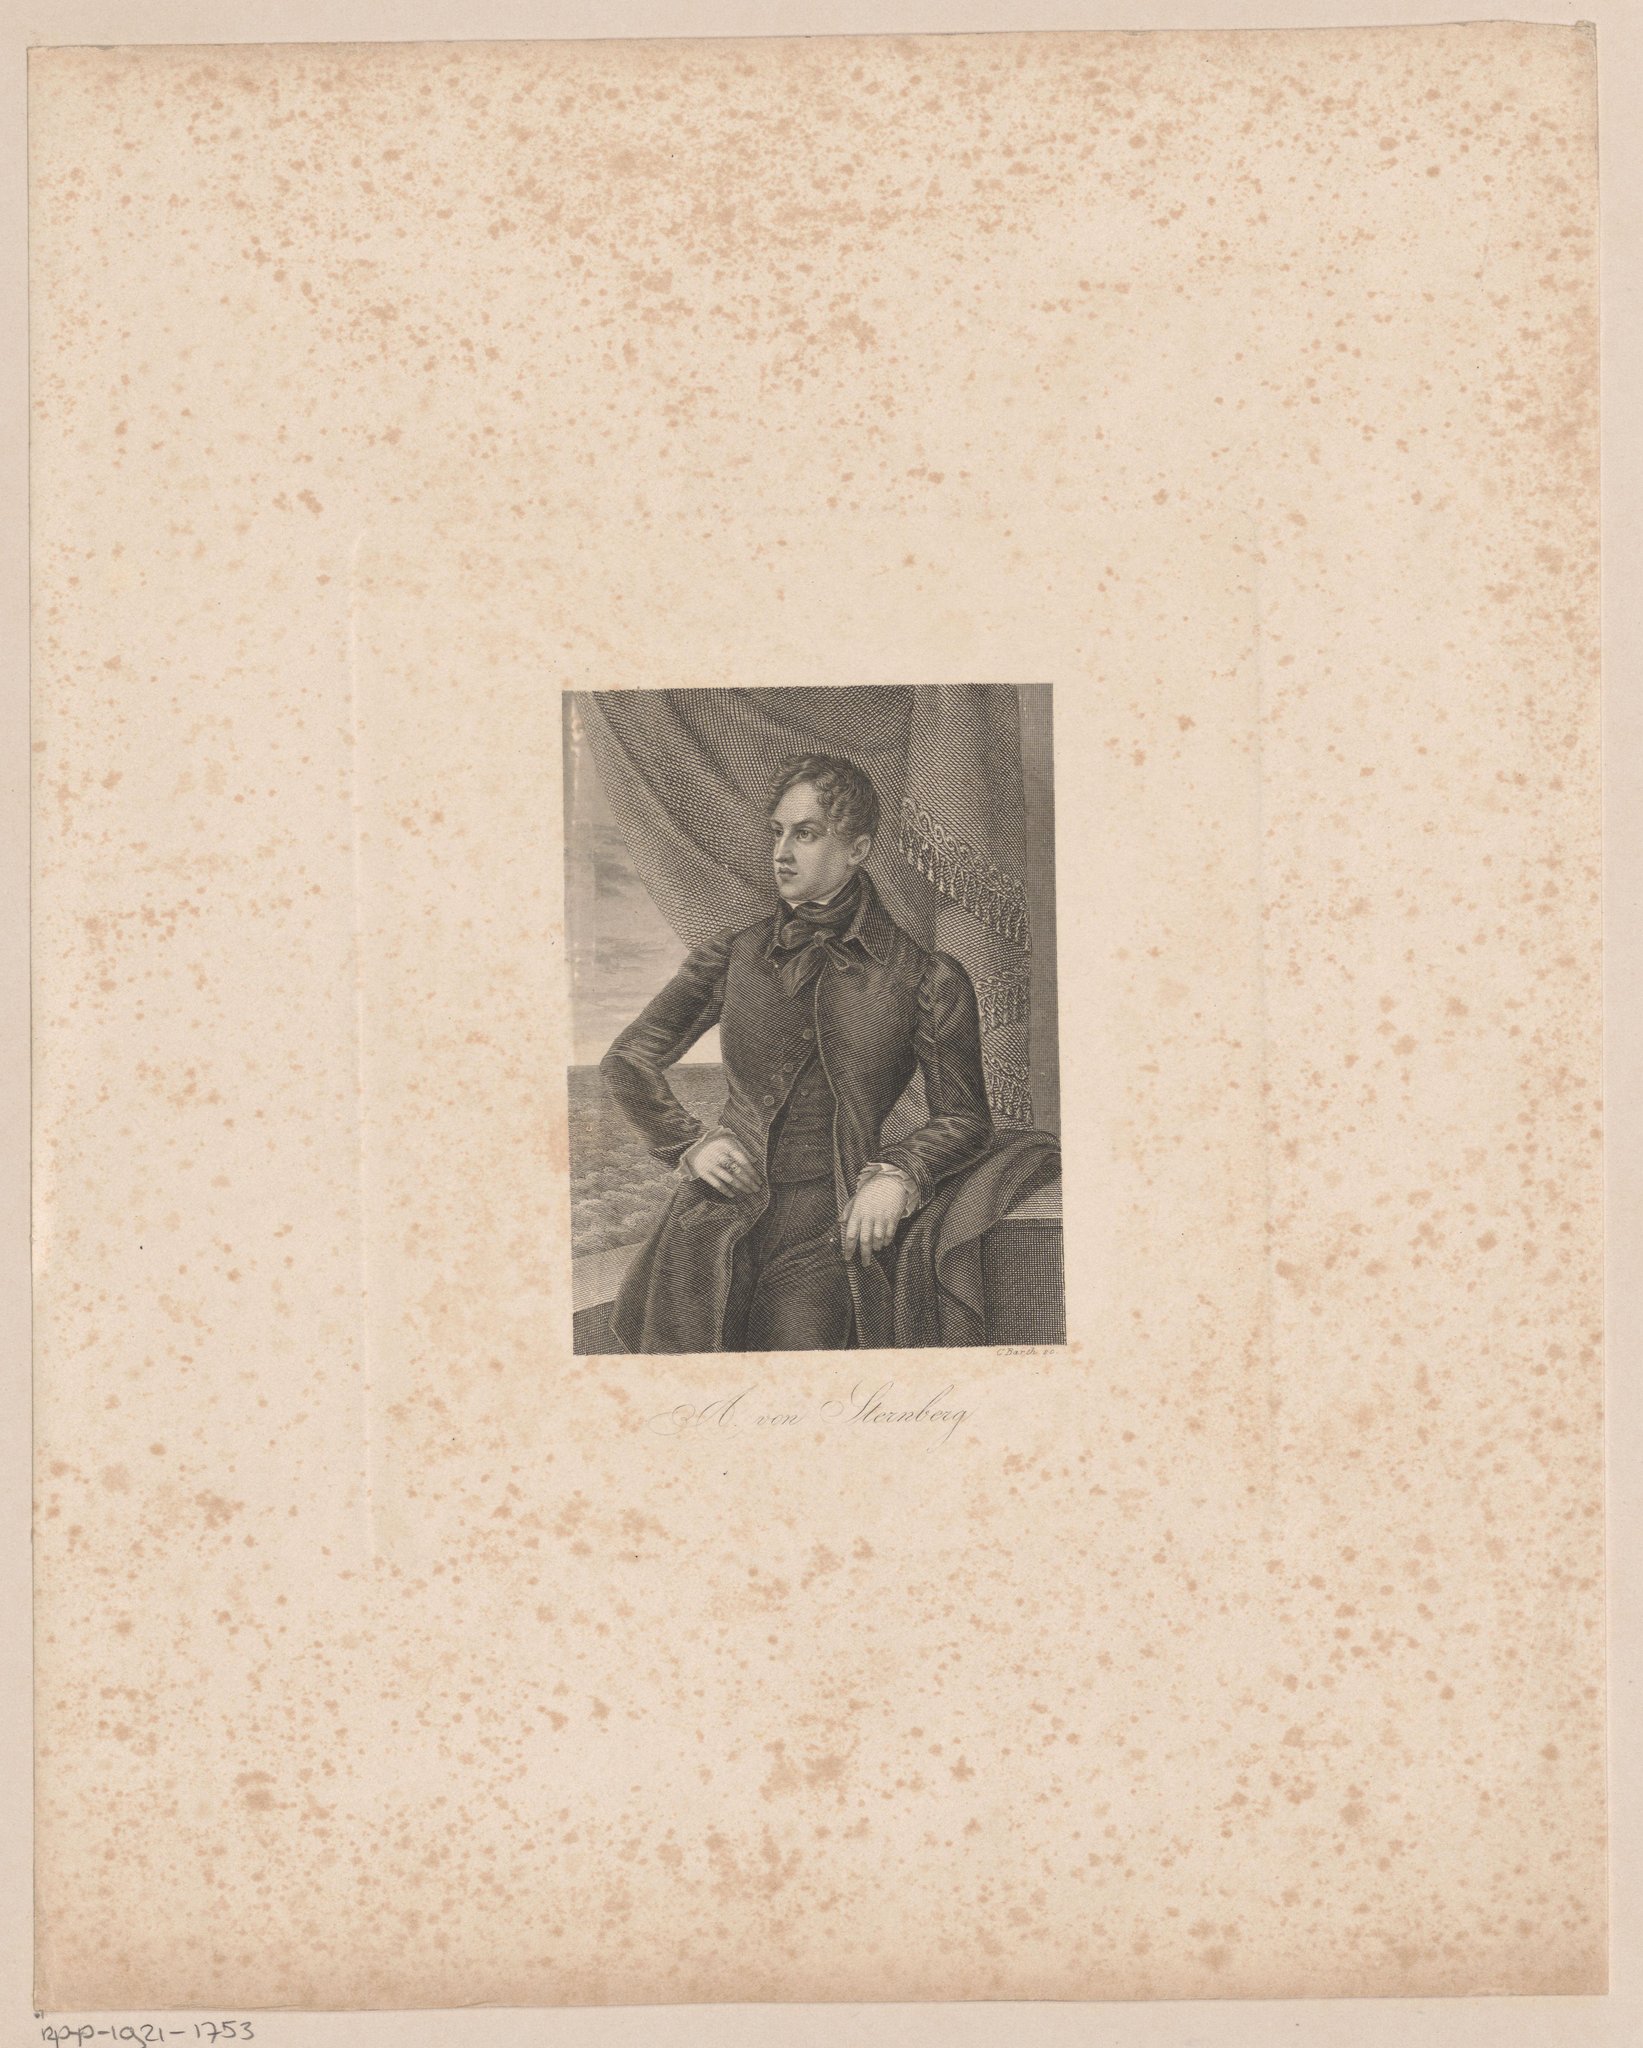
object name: print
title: Portret van Alexander von Ungern-Sternberg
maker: karl barth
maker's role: print maker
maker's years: 1787-1853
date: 1826-1853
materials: paper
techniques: engraving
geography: germany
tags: historical persons, portrait of a writer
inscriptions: collector's mark: Lugt 2233